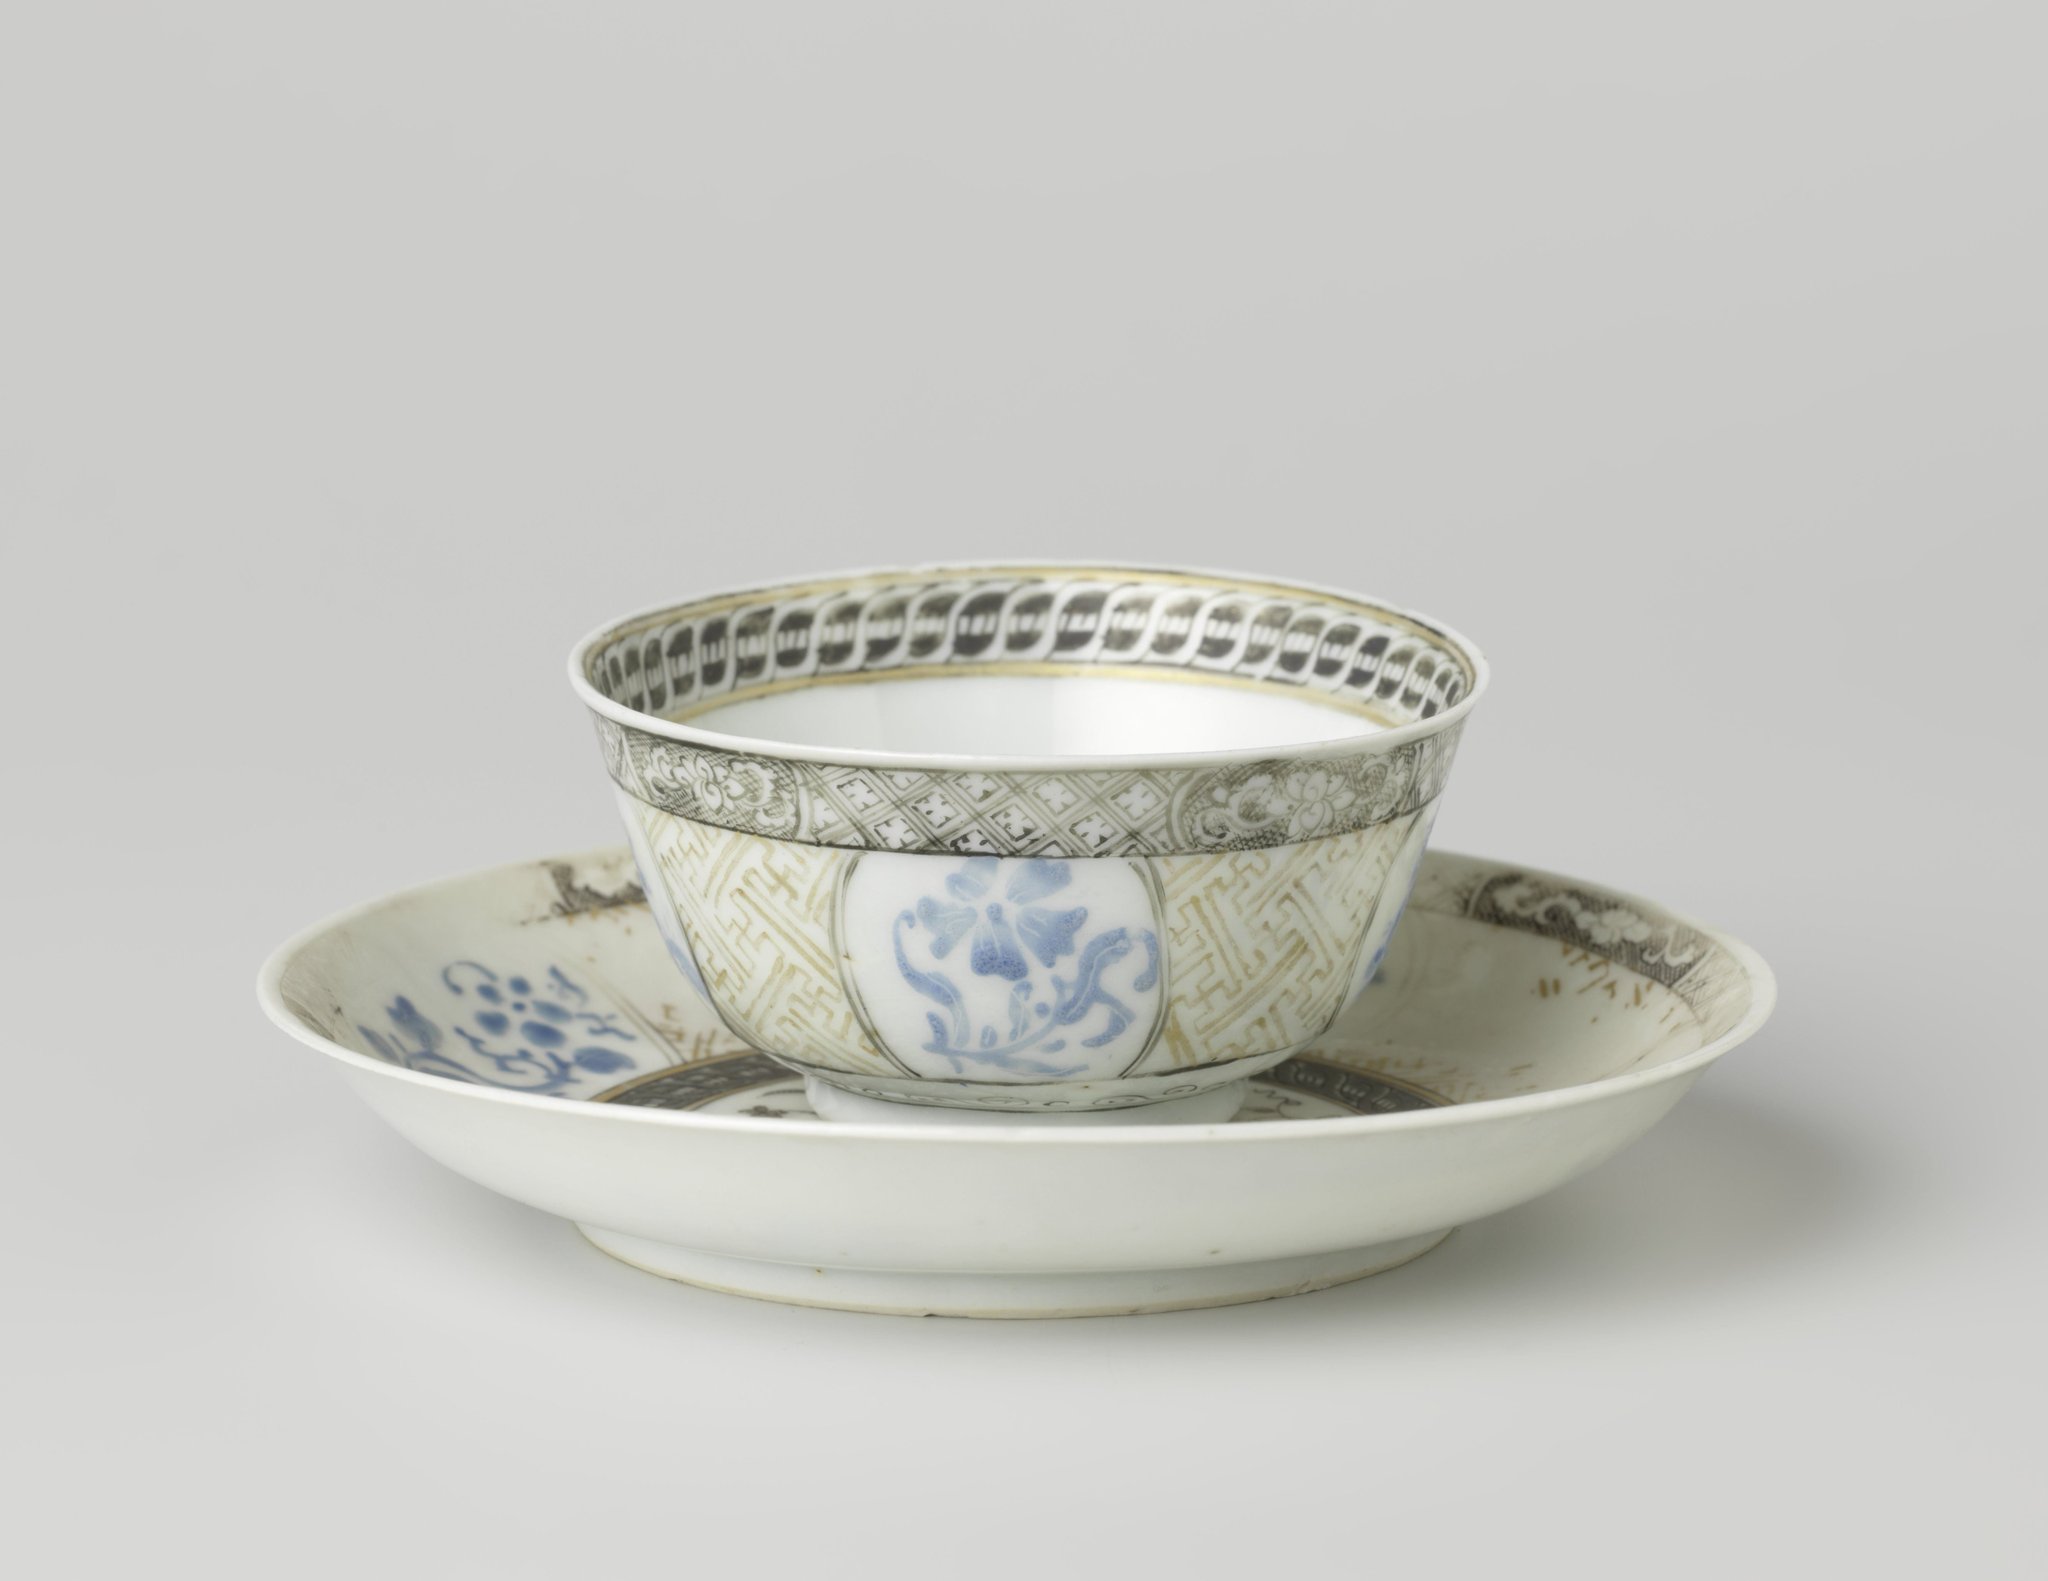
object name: kop en schotel, kop en schotel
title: Bell-shaped cup and saucer with flower sprays and ornamental borders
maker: Anonymous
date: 1725-1749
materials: glaze, gold, paint, porcelain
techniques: firing, gilding, turning, vitrification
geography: china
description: Kop en schotel met bloemen in encre de chine en een rand met bloemen in zwart en goud .